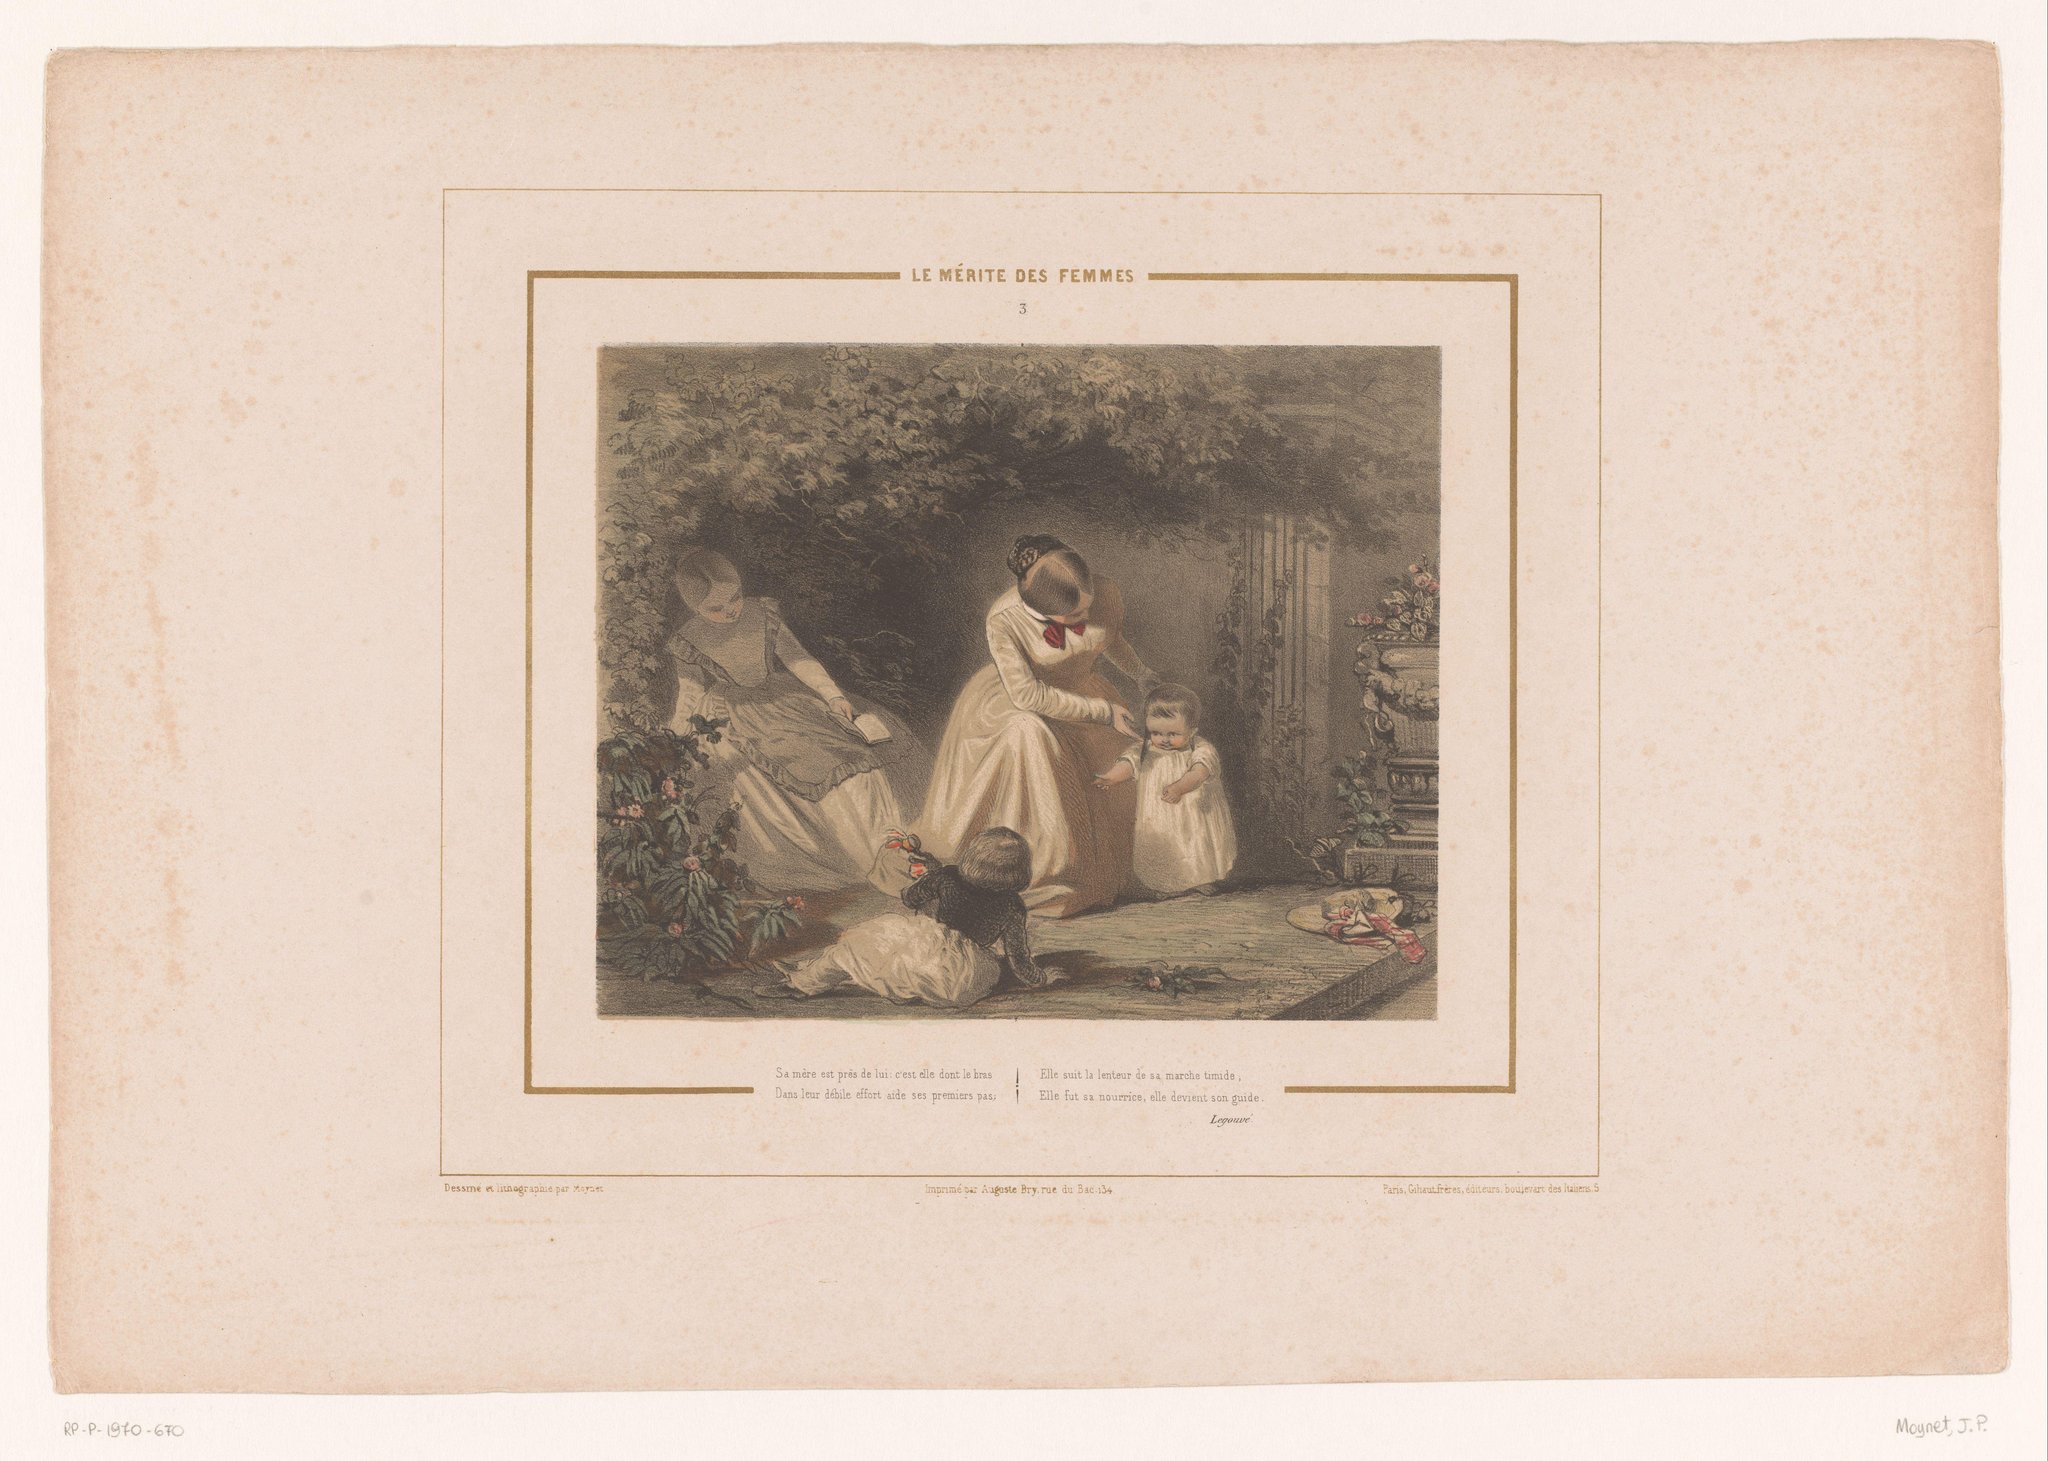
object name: print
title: Kind zet eerste stapjes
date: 1831-1871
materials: paper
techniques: hand coloring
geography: paris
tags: playing toddler; child amusing itself, mother and baby or young child, infant, baby, learning to walk, the first steps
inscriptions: inscription: ‘v. Stockum, 24 Nov. 1964/ No. 172 (81 st.) f. 520-’, collector's mark: Lugt 2228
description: Onder een deel van het gedicht 'Le mérite des femmes' van Gabriel-Marie Legouvé: Sa mère est près de lui: c'est elle dont le bras. Dans leur débile effort aîde ses premiers pas; Elle suit la lenteur de sa marche timide, Elle fut sa nourrice, elle deveniet son guide.